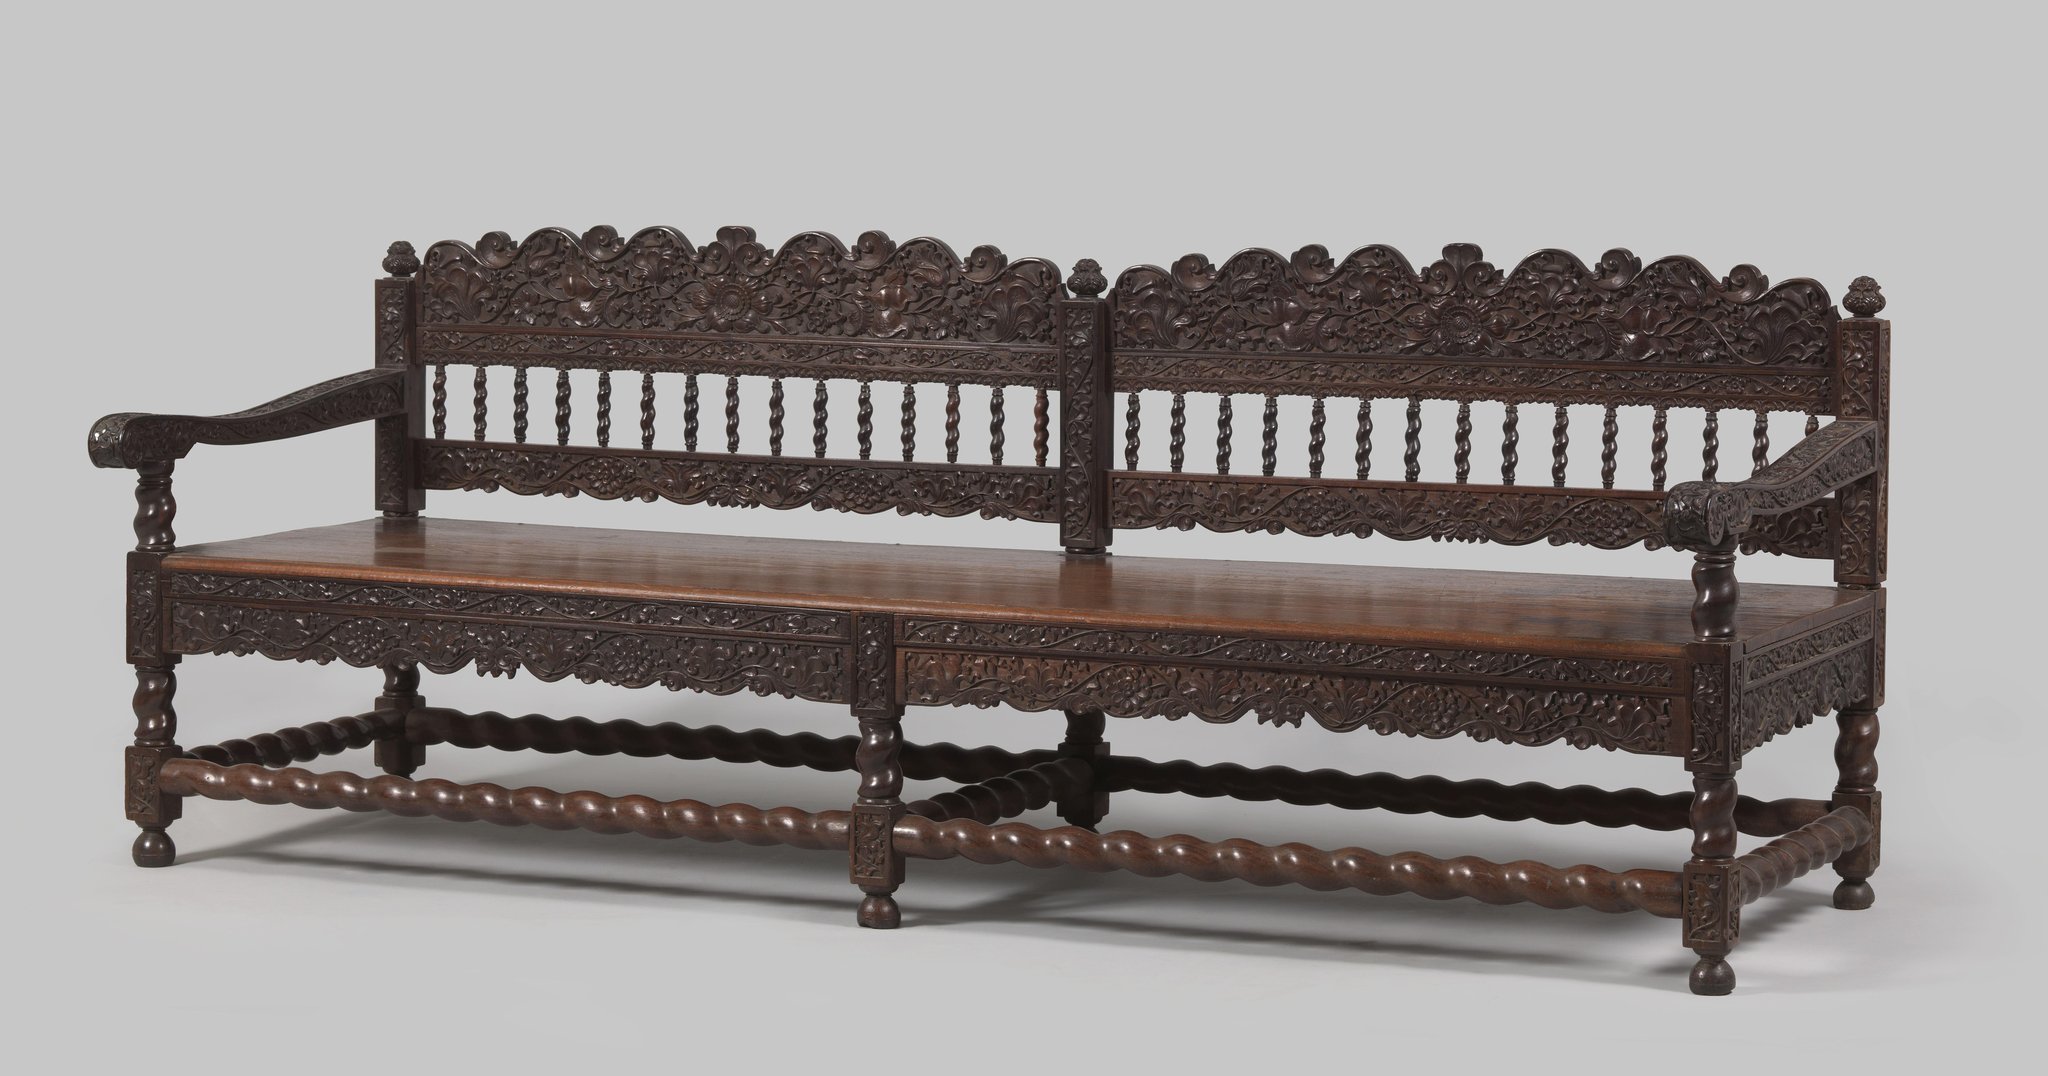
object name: sofa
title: Bank op zes geslingerde poten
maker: Anonymous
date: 1600-1649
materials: wood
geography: jakarta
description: Bank van ijzerhout (?) op zes geslingerde poten met huizen, rustend op platte bolvormige voetklossen en verbonden door geslingerde voetregels. De geslingerde armleggerstutten steunen de licht geholde armleggers, eindigend in een voluut, die in de vierkante rugstijlen, door lotuskelken bekroond, overlopen. De rug, met geschulpte bovendorpel bestaat uit twee delen; de dorpels zijn door geslingerde zuilen verbonden en, evenals de zitregels, huizen, stijlen en armleggers versierd met gestoken lotusranken.